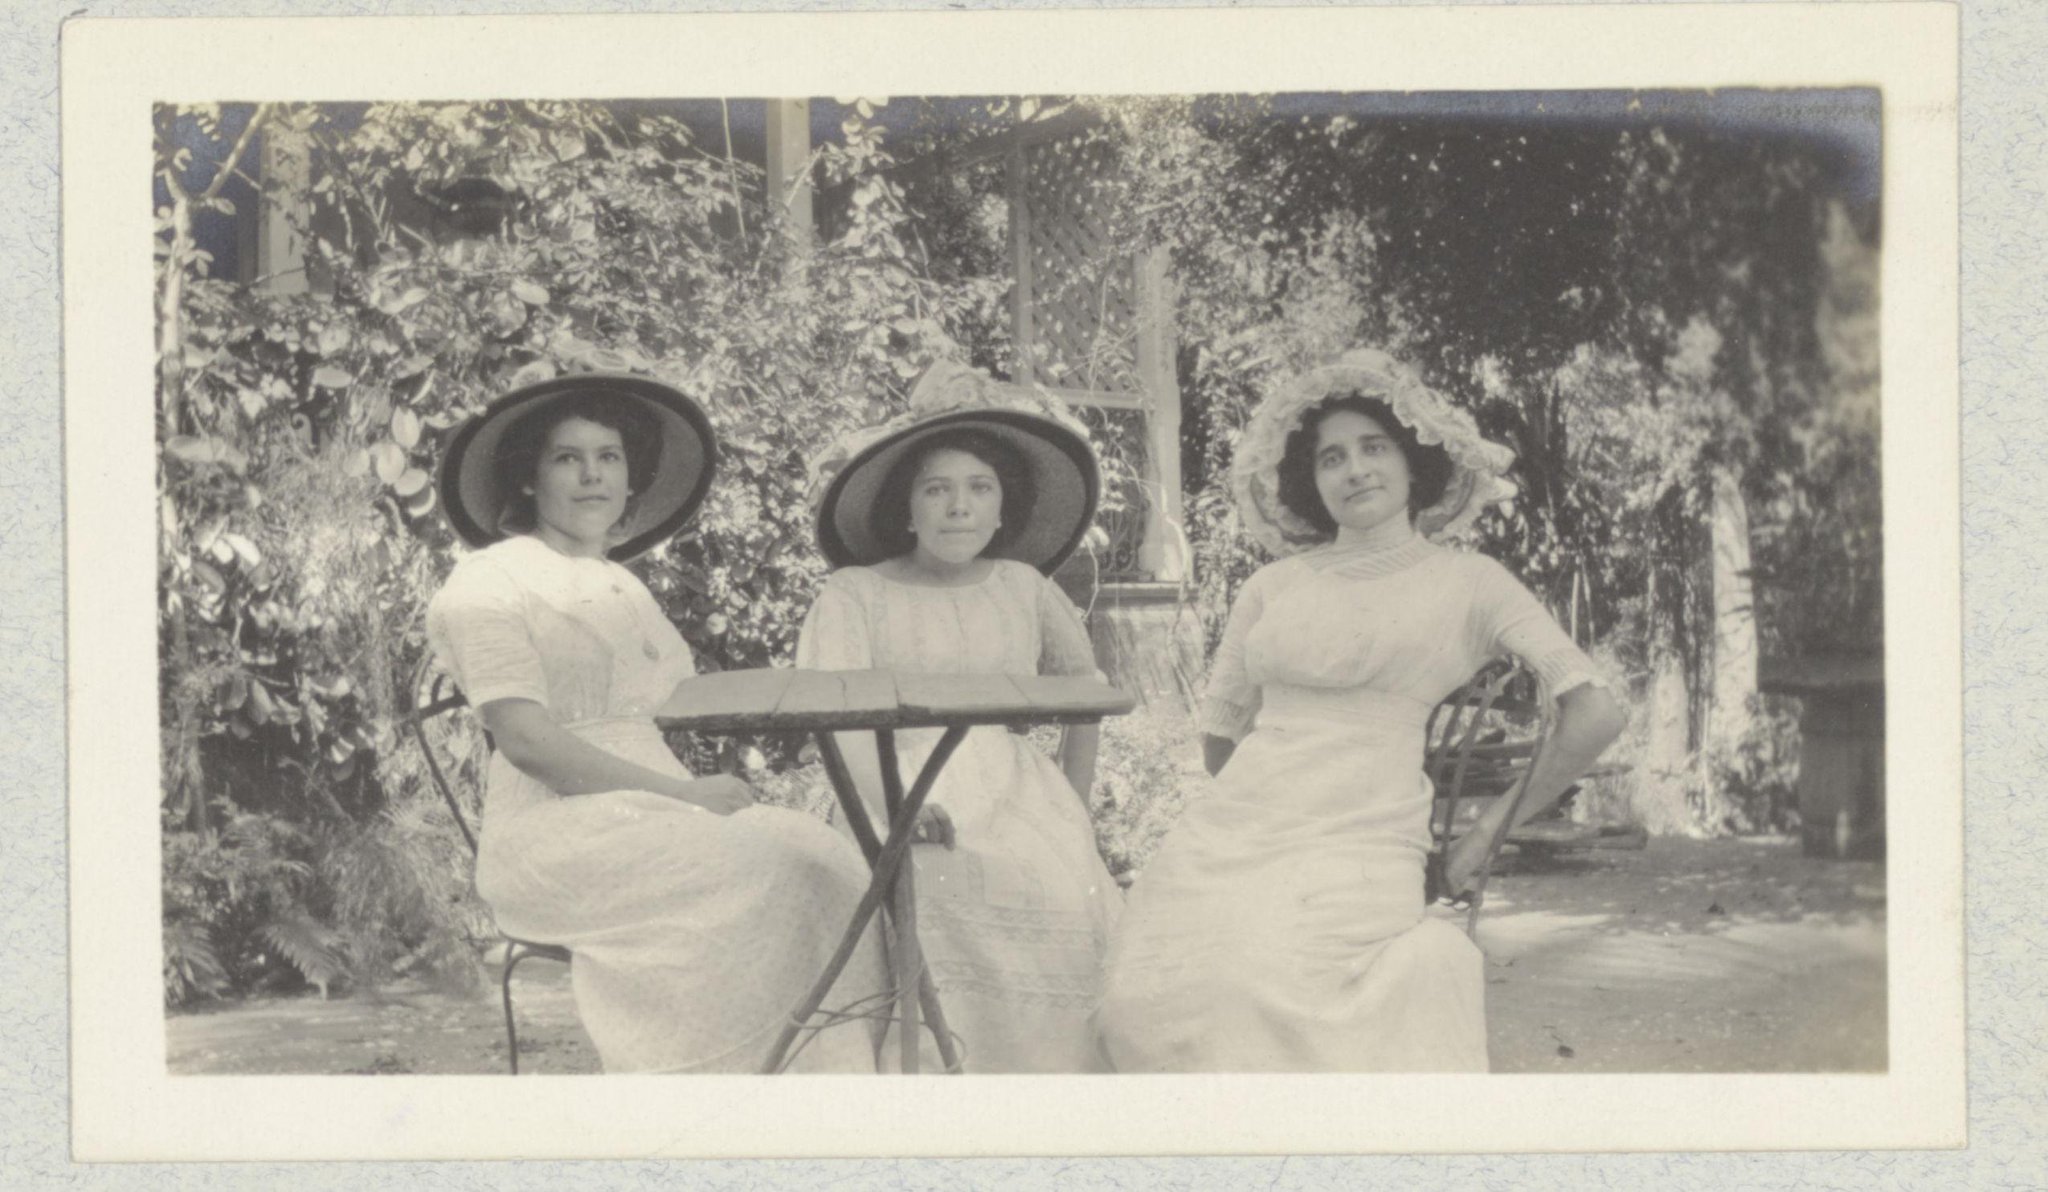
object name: photograph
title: Jongedames in Port-au-Prince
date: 1905-1912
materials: photographic support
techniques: photography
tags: port-au-prince, haïti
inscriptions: inscription: ‘Edith von Heydebrand und der Lasa / Fernande d'Aubignuy / Nini Coles / P. au P. Mei 1912’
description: Portret van drie jongedames die zittend aan een tafeltje poseren, in Port-au-Prince op Haïti, mei 1912. Onderdeel van het fotoalbum van de familie Boom-Gonggrijp in Suriname en Curaçao.